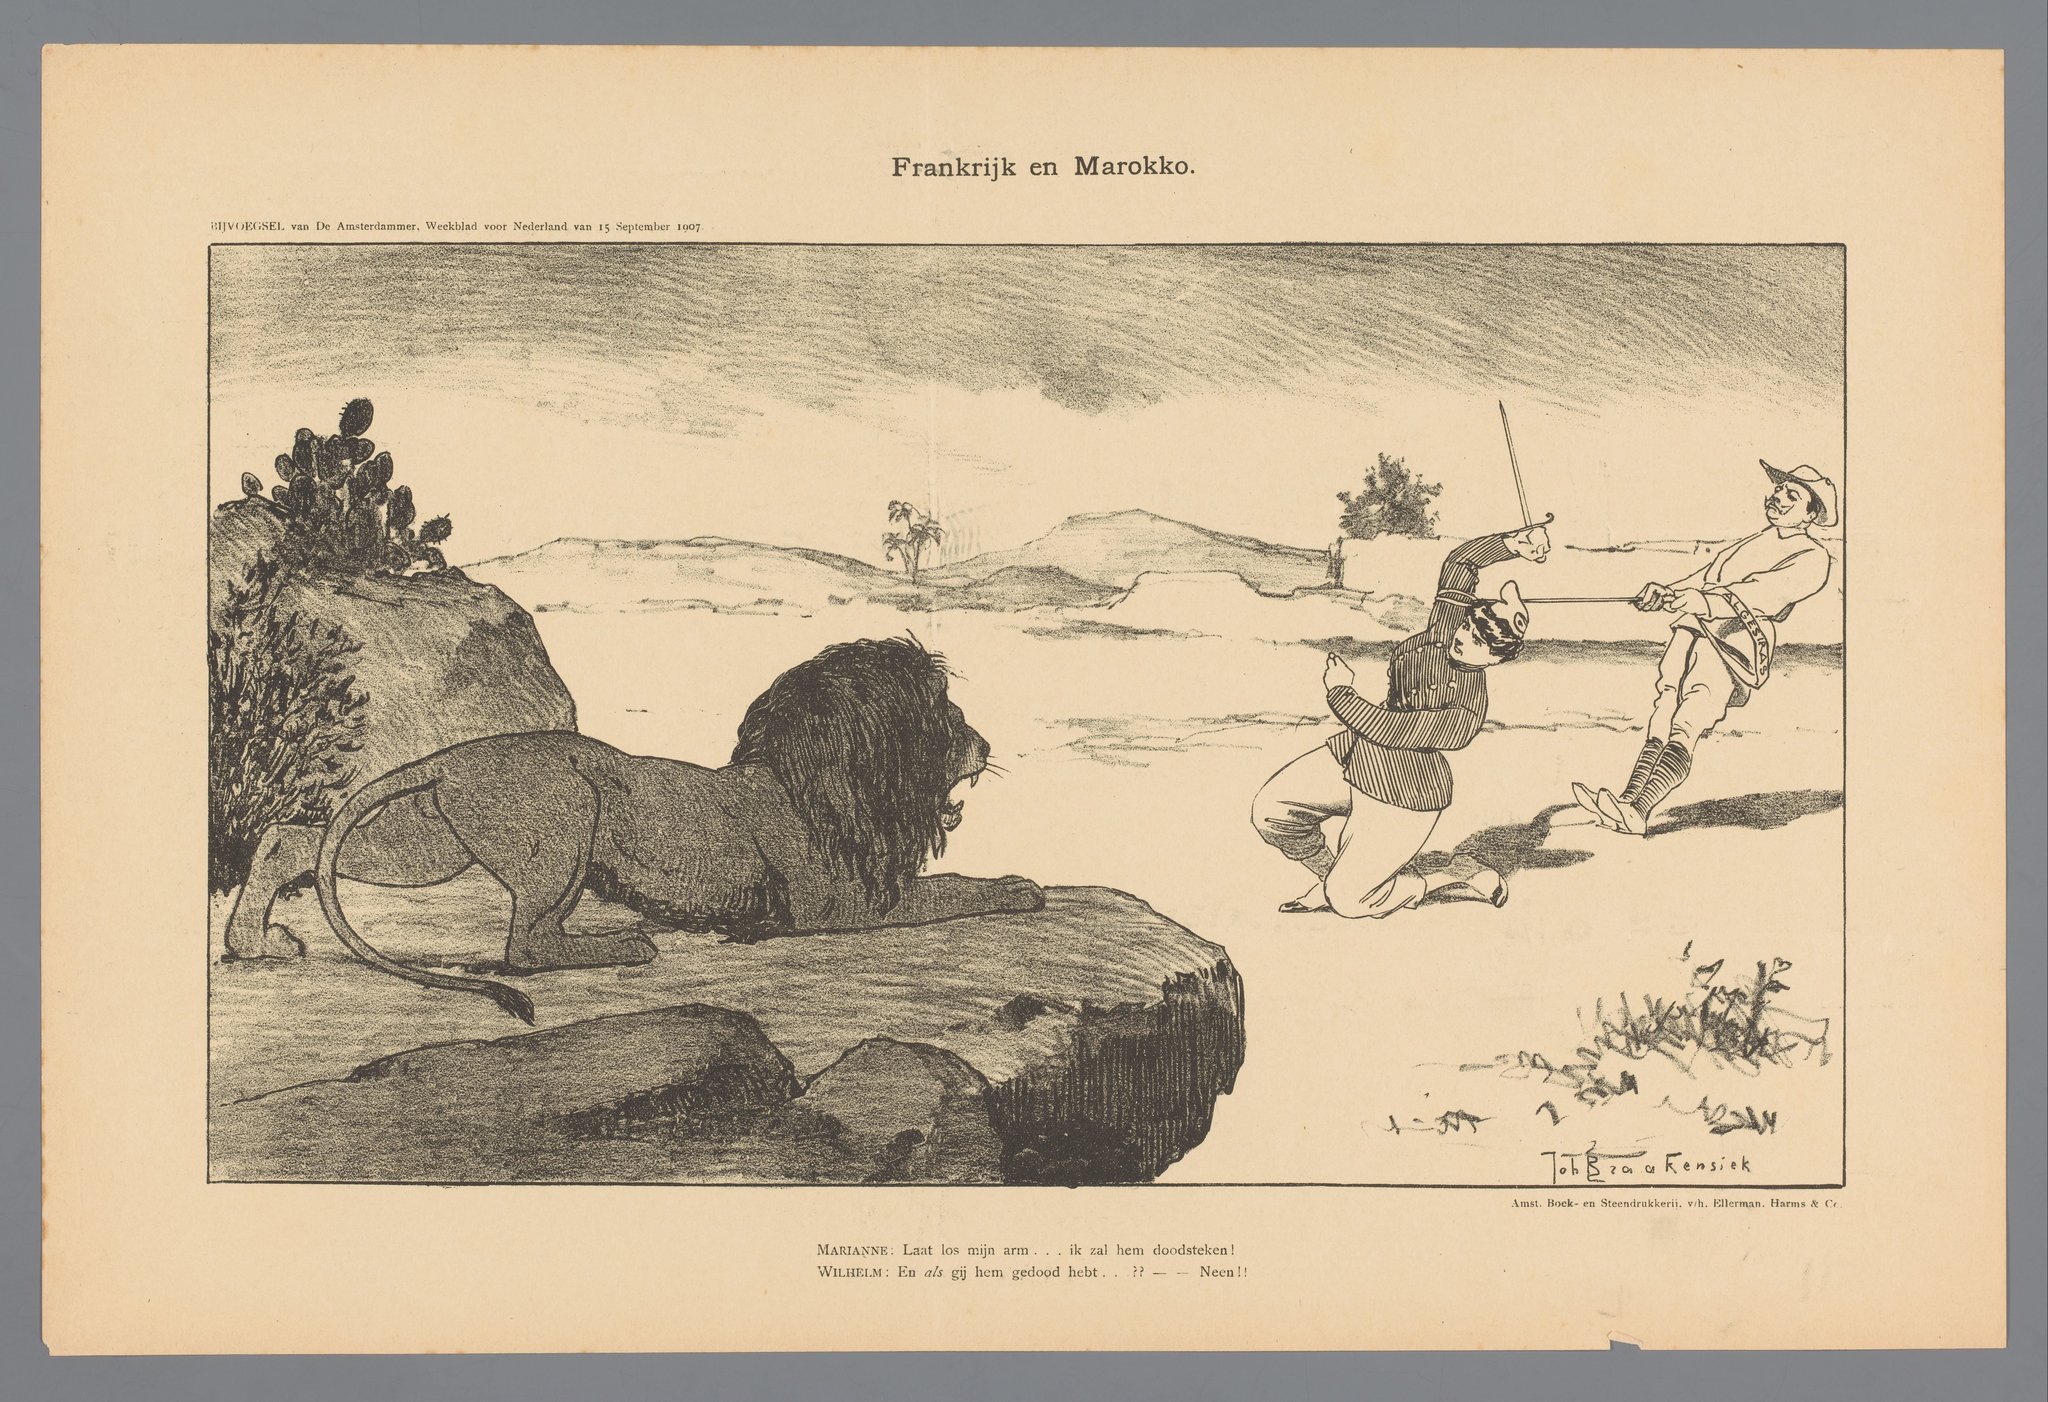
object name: cartoon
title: Frankrijk en Marokko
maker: johan braakensiek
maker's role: draughtsman, print maker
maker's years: 1858-1940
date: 1907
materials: paper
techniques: lithograph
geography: amsterdam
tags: wilhelm ii (keizer van duitsland), ruler, sovereign, personifications of countries, nations, states, districts, etc. (+ nation; national), beasts of prey, predatory animals: lion, political caricatures and satires, france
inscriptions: date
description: Prent uit het bijvoegsel van: De Amsterdammer. Weekblad voor Nederland, 15 september 1907.